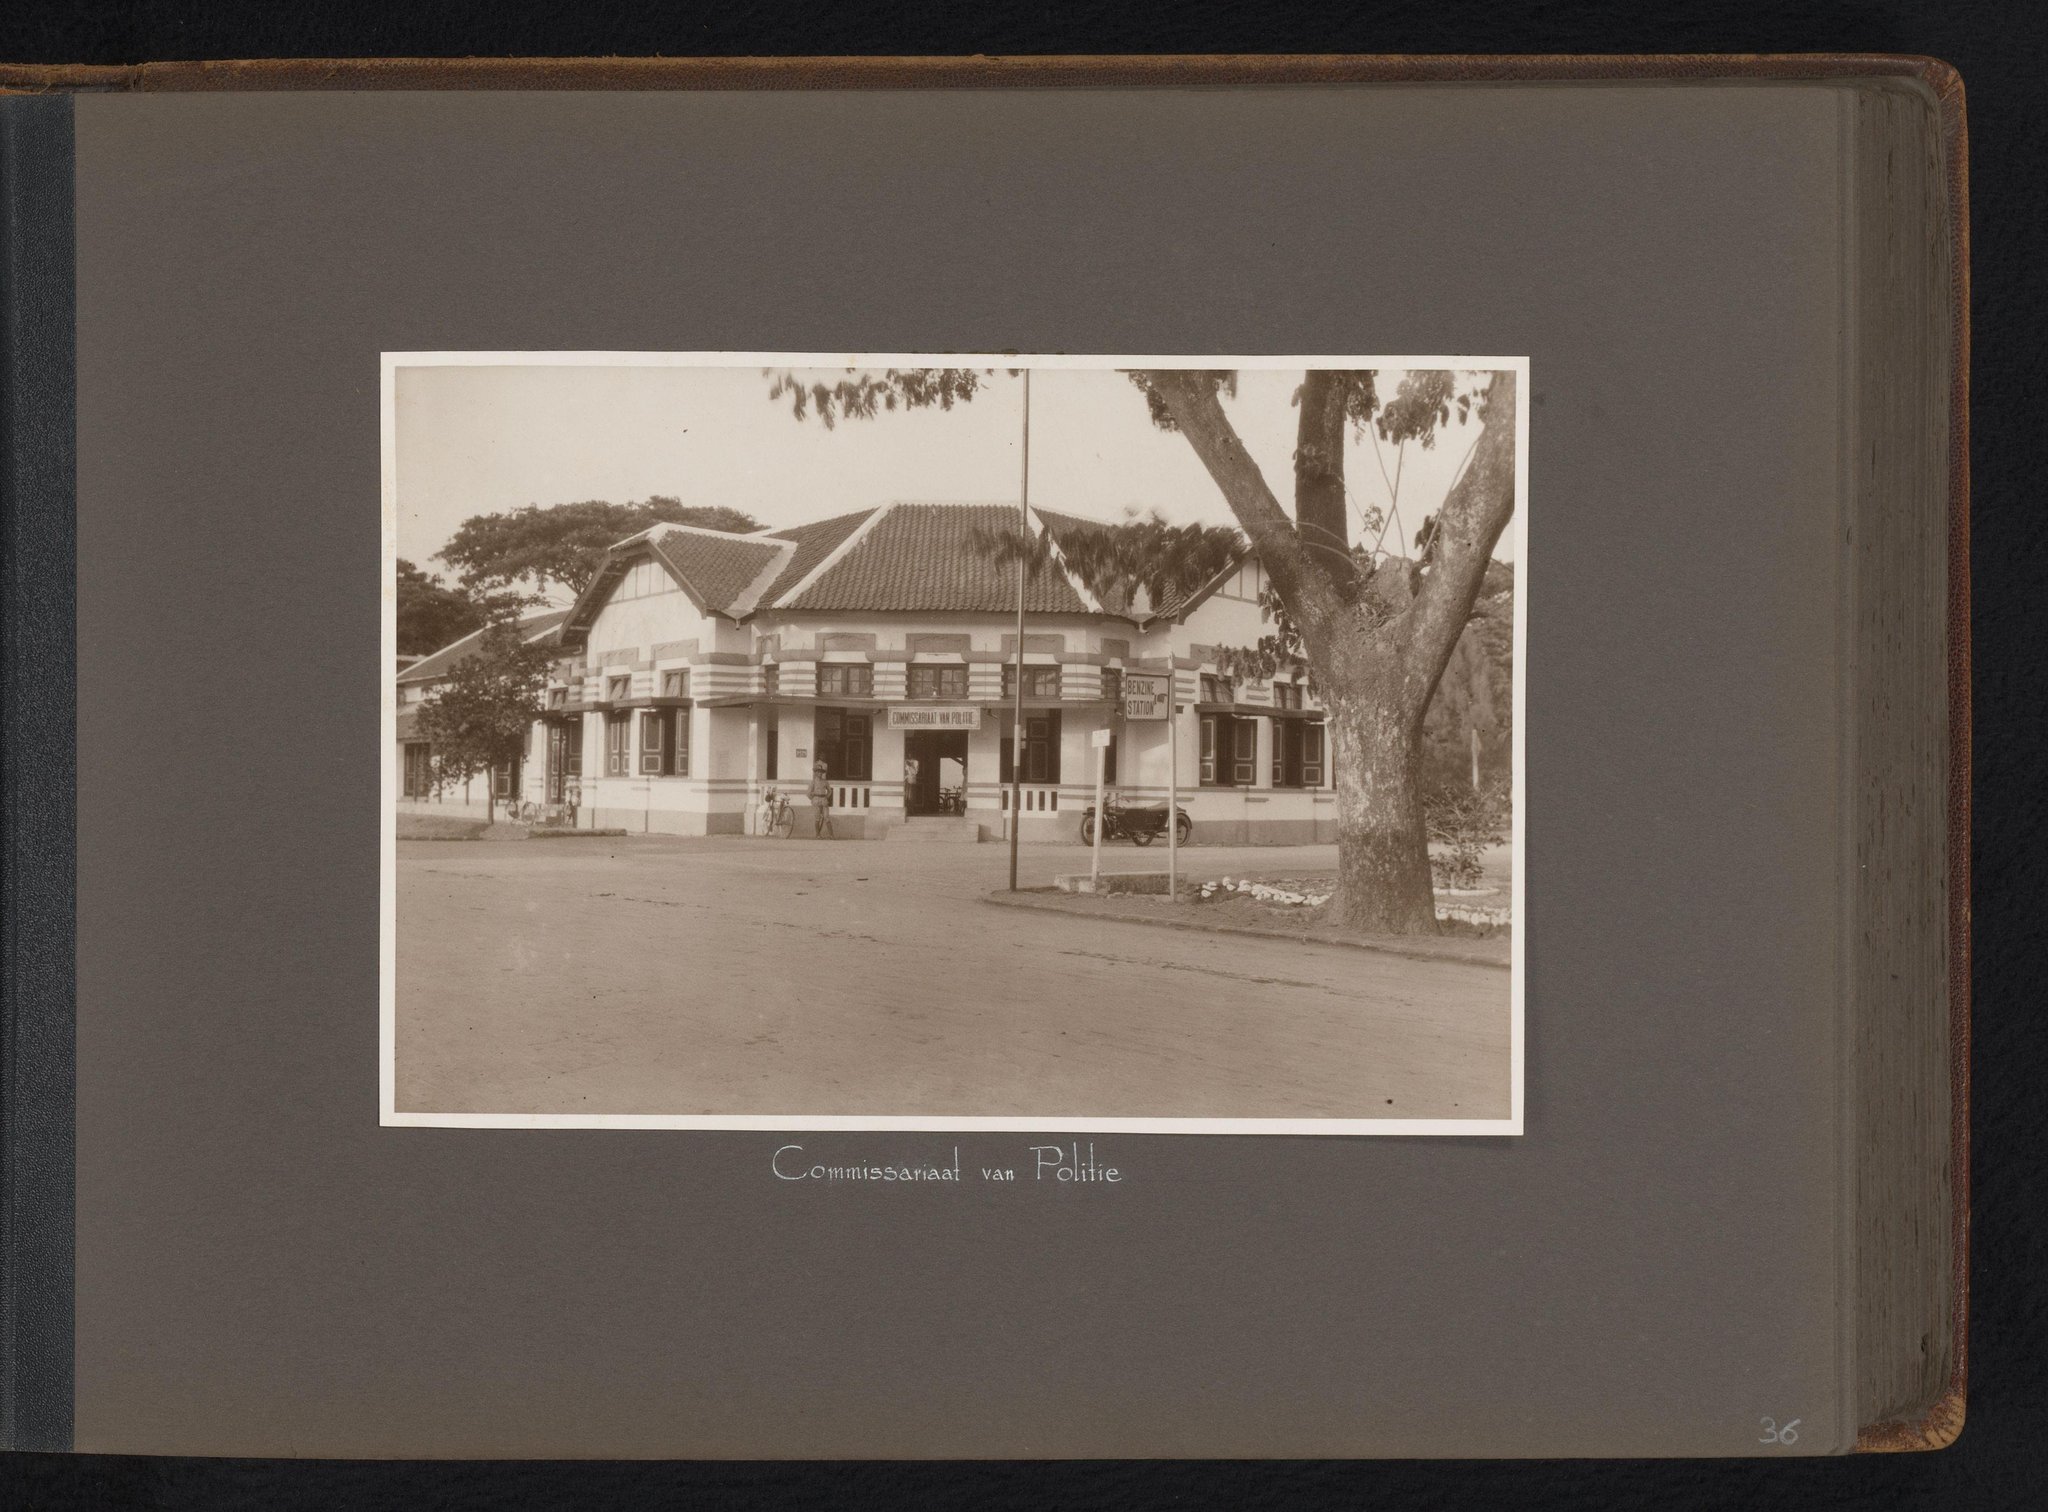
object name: photograph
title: Commissariaat van Politie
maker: Anonymous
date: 1925-1931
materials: cardboard, photographic support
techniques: gelatin silver print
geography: solo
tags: dutch east indies, the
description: Albumblad met één foto: het gebouw van het commissariaat van politie te Solo. Onderdeel van het fotoalbum aangeboden aan S. Koster door de Vereeniging van Hoogere Politie Ambtenaren in Nederlandsch-Indië in 1931.